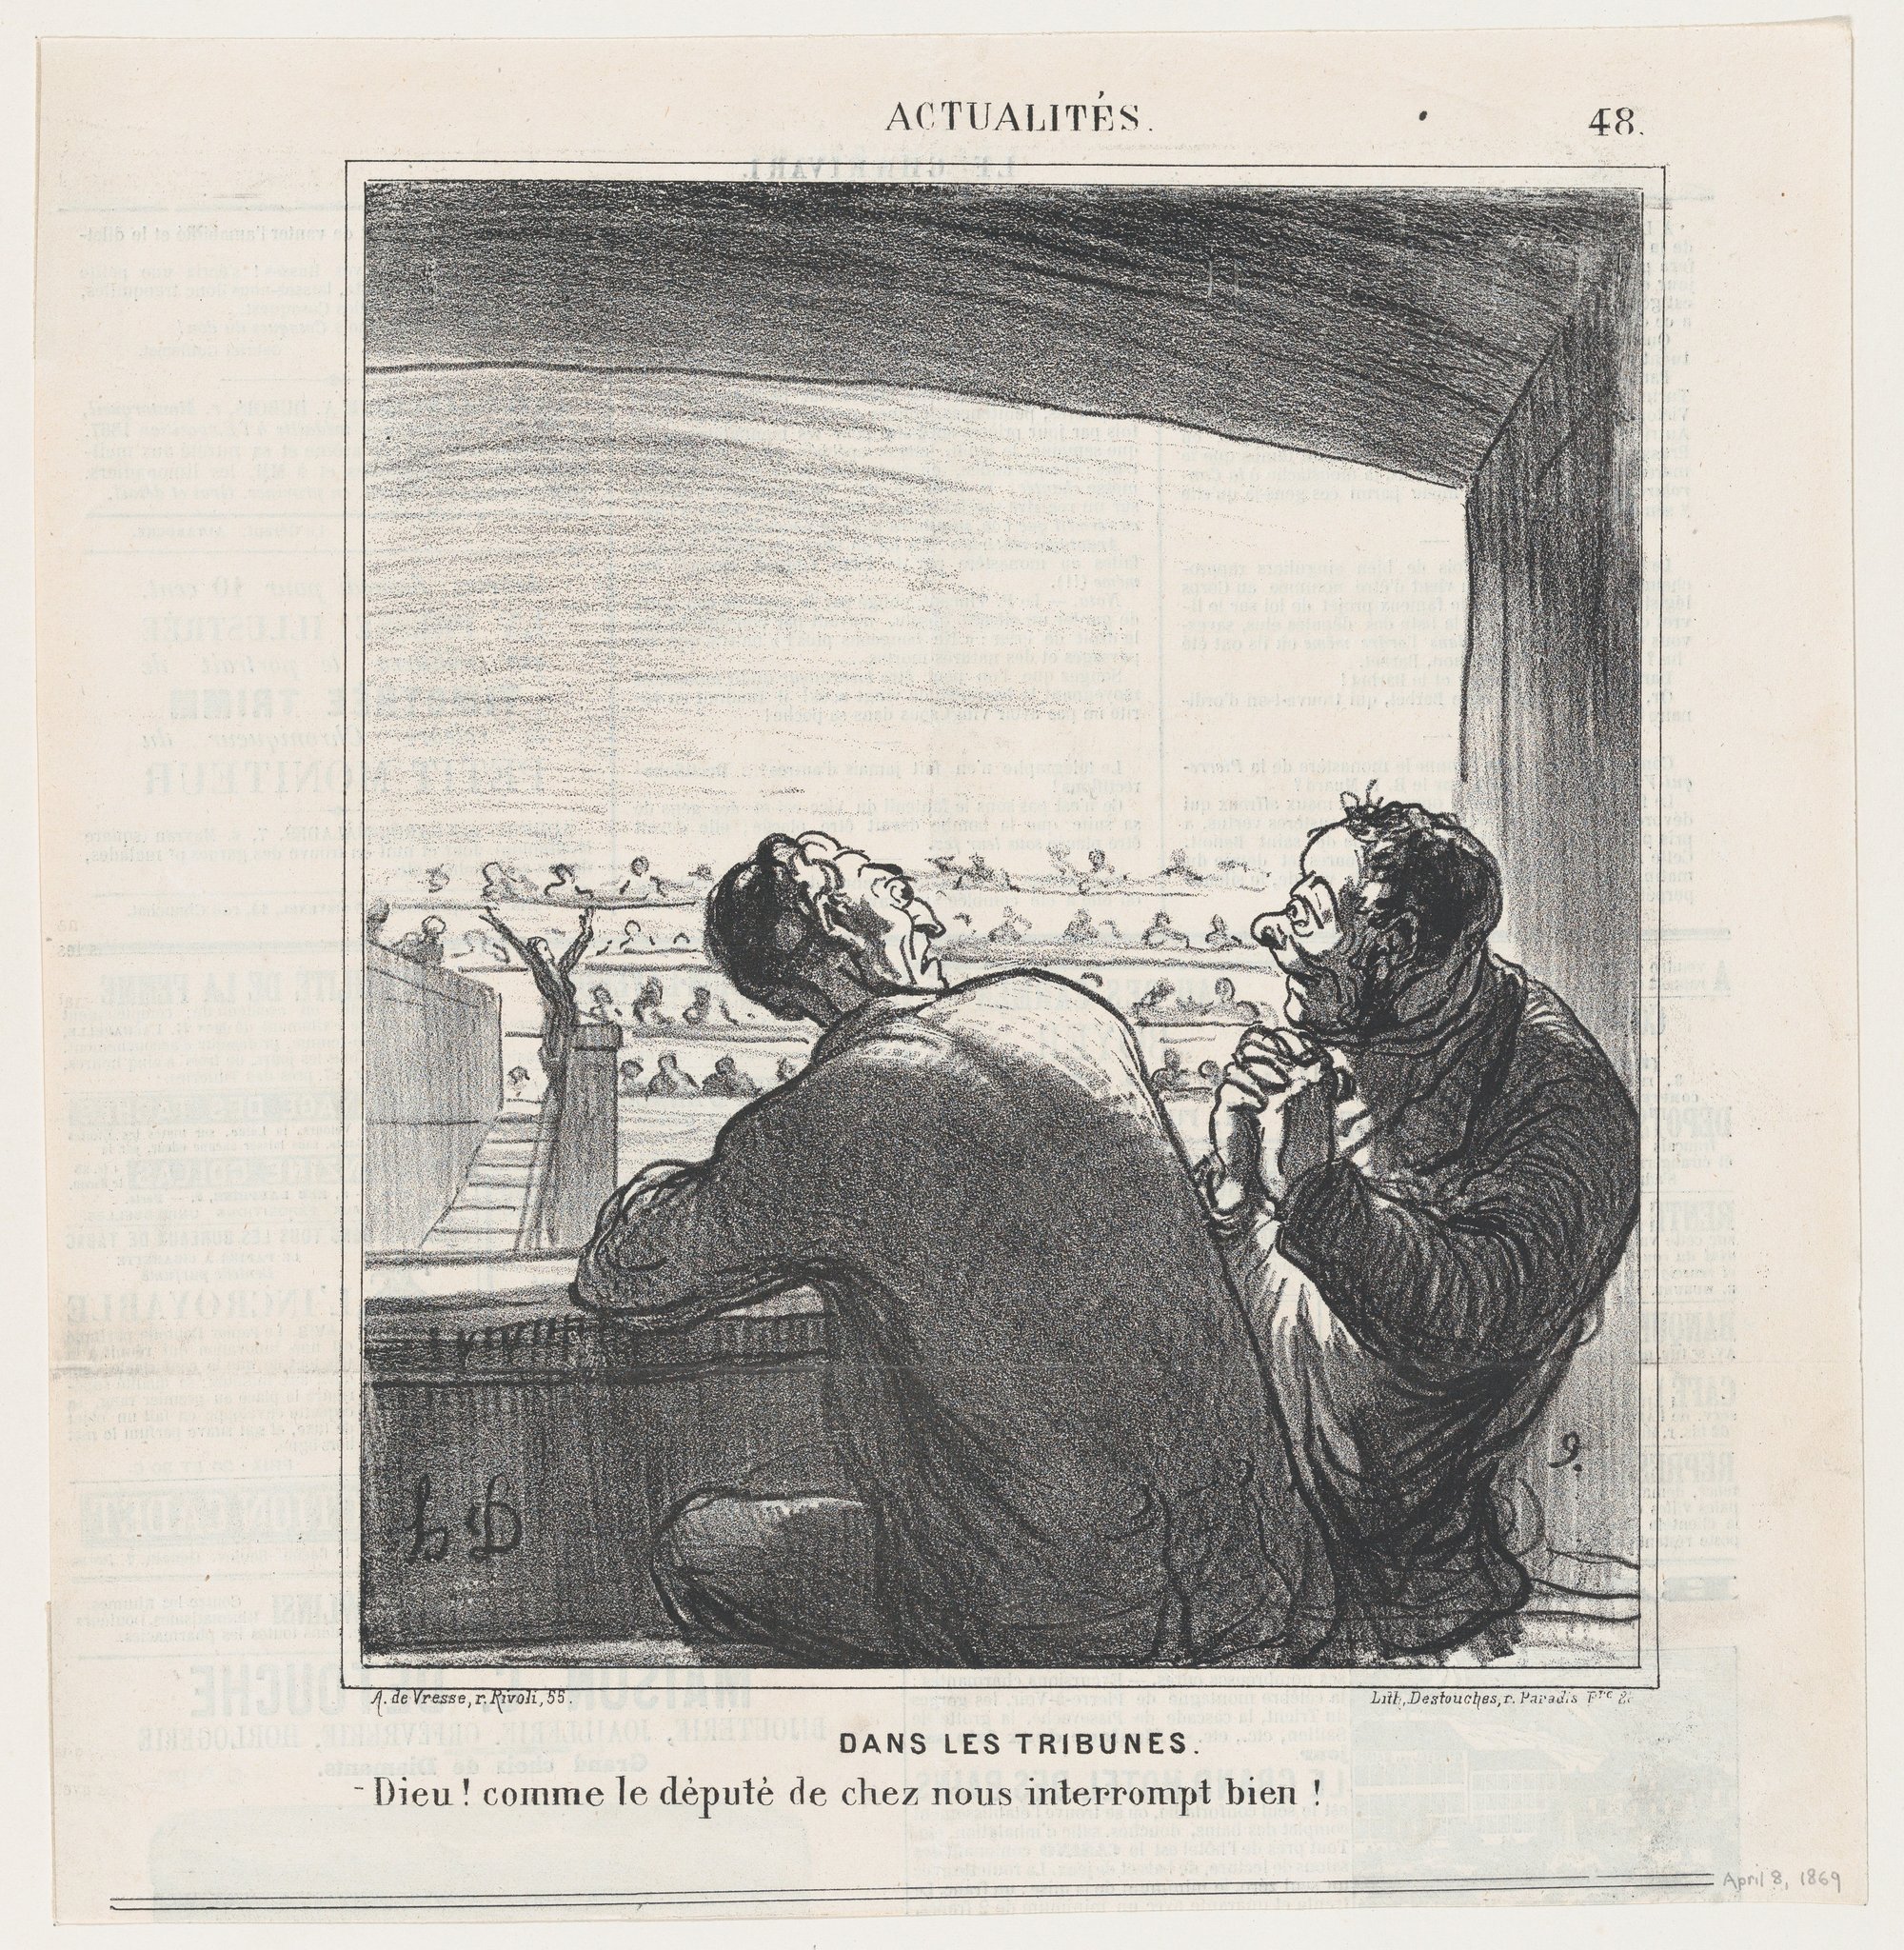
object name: print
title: At the visitors tribune: God, our Deputy is good at interrupting!, from 'News of the day,' published in Le Charivari, April 8, 1869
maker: honoré daumier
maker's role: artist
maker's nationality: french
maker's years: 1808-1879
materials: paper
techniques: lithograph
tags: men